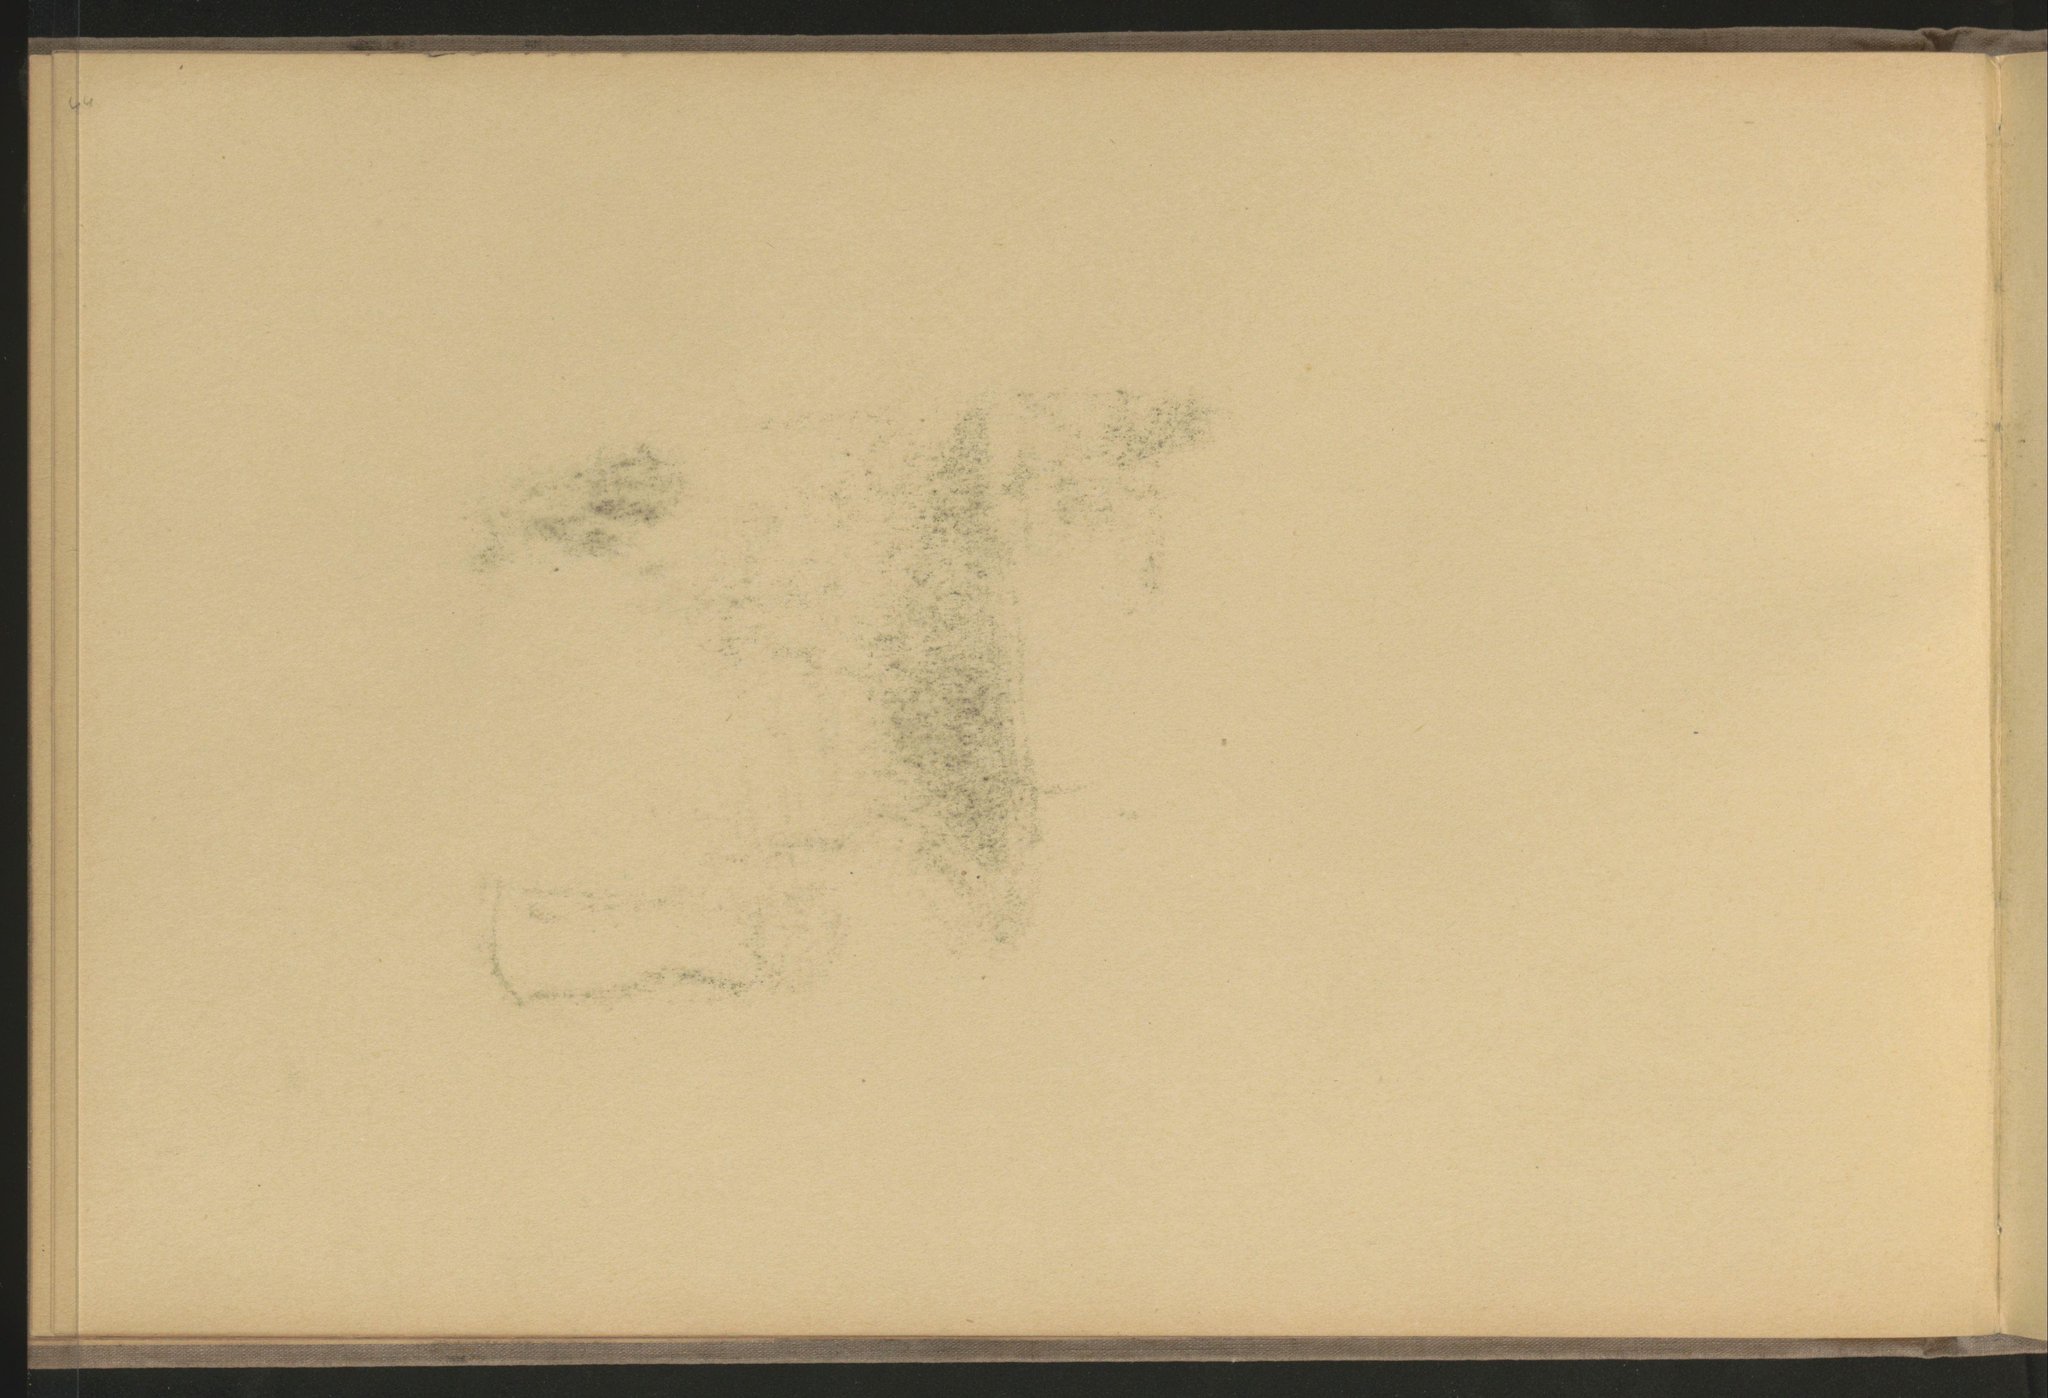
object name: sketchbook leaf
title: Abklatsch van de krijttekening op pagina 45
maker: willem witsen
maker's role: draughtsman, painter, print maker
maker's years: 1860-1923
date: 1901-1907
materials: paper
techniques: printmaking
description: Pagina 44 uit een schetsboek met 60 bladen.